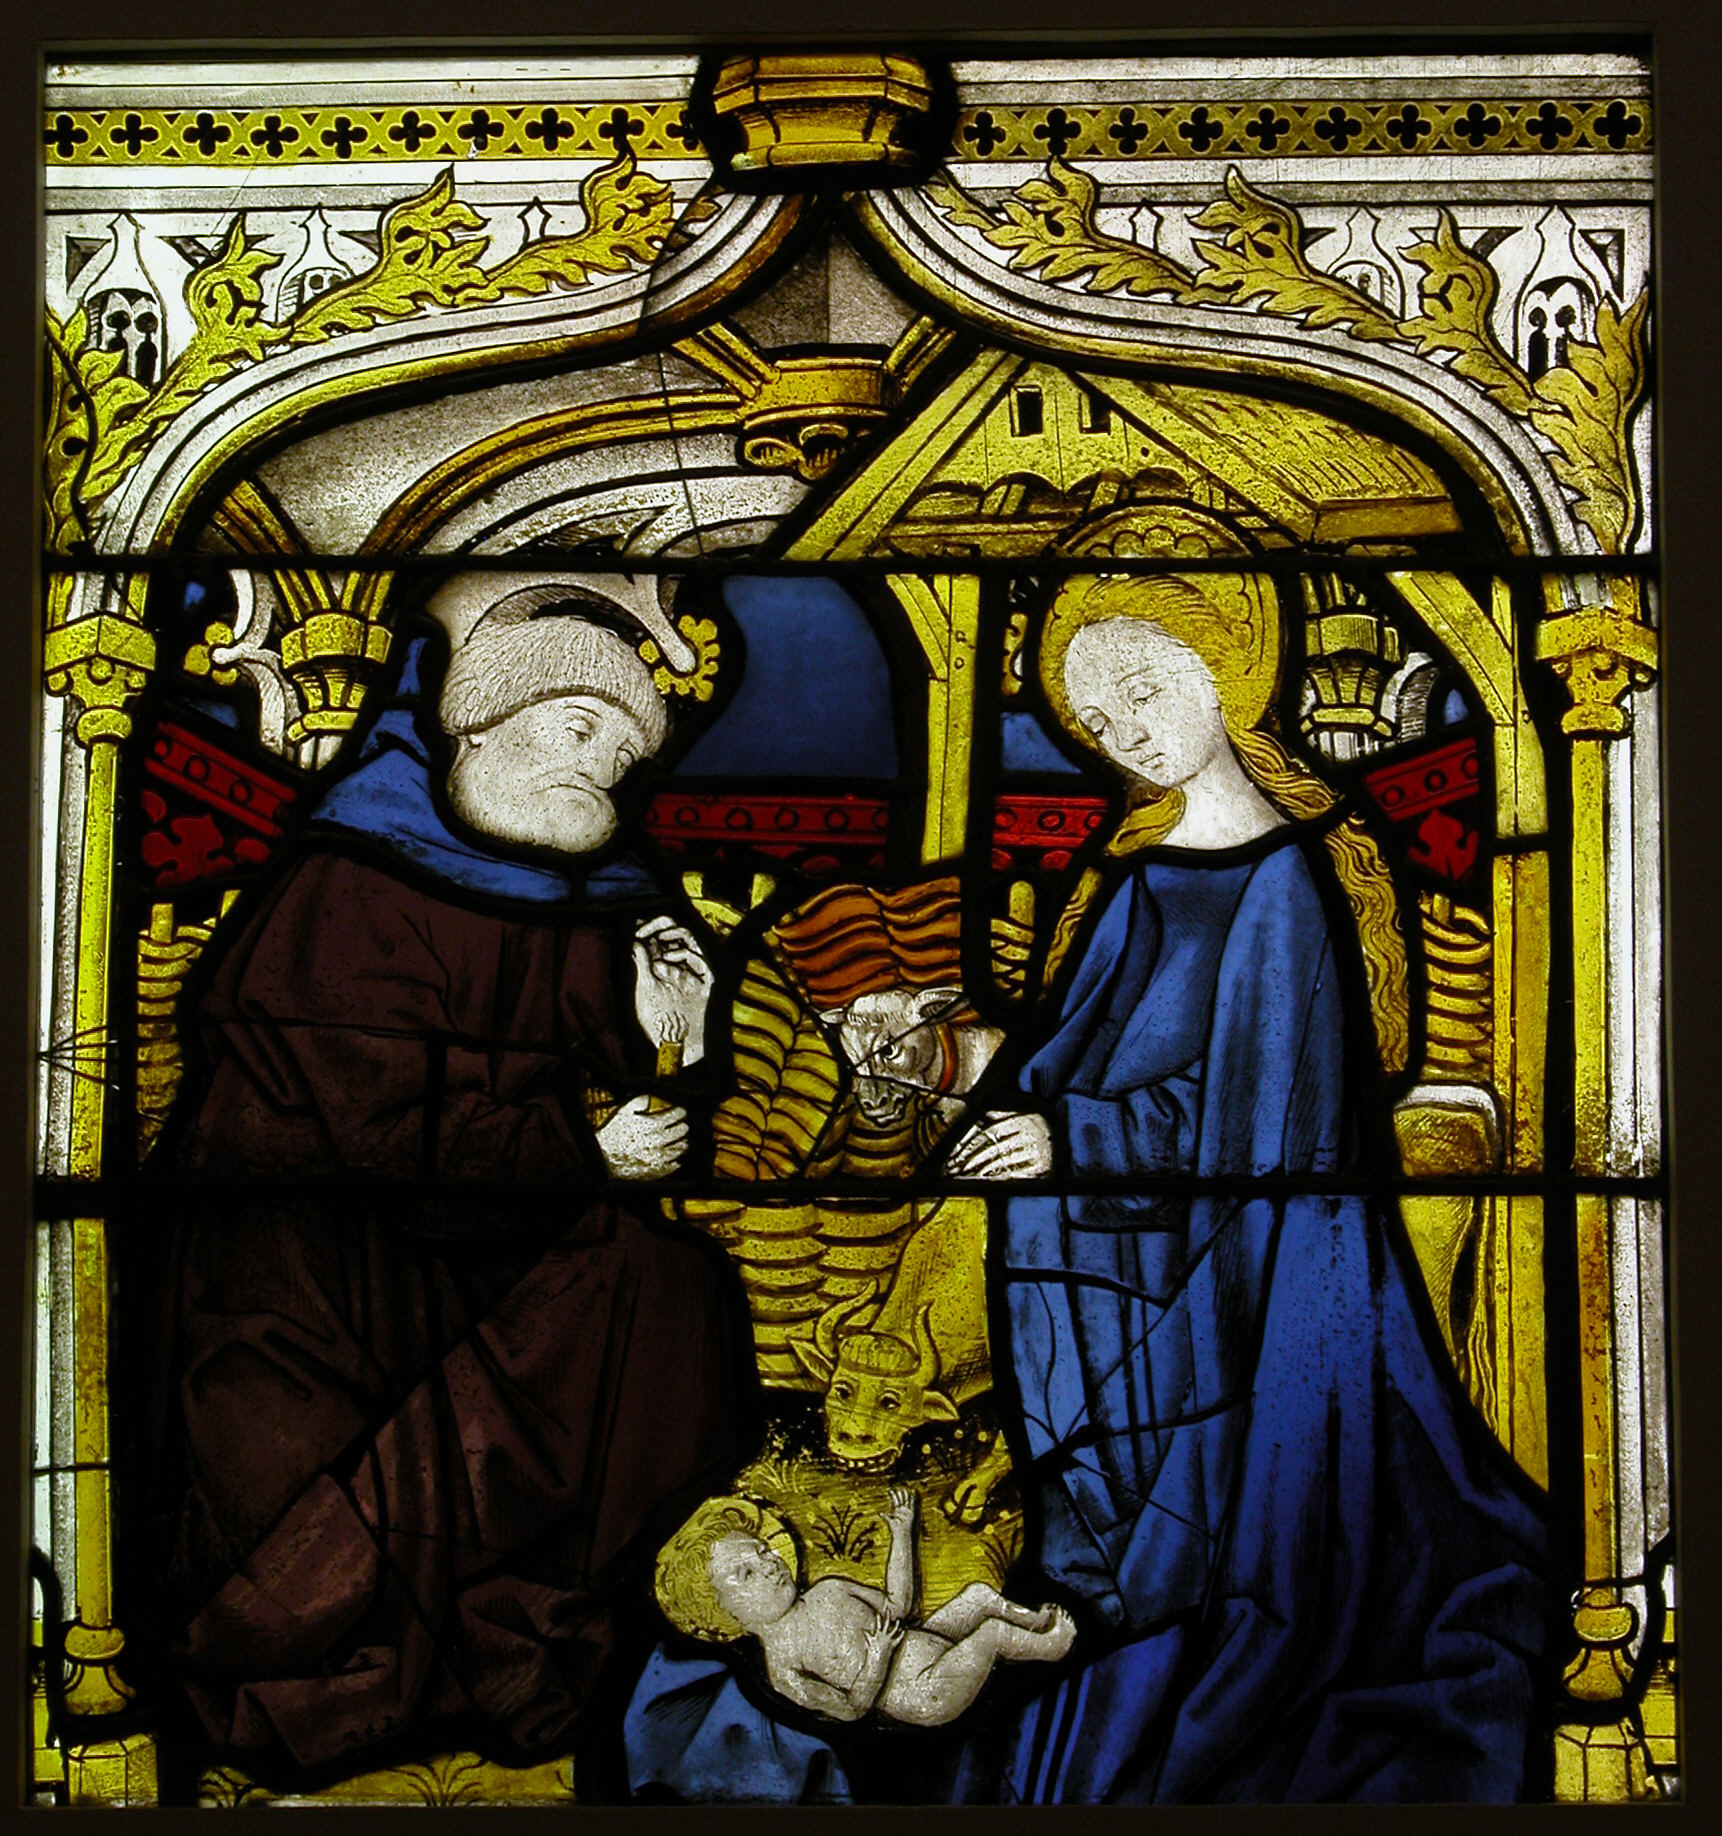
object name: panel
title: The Nativity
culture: french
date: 1440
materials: glass, metal, paint, pigment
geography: france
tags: animals,christ,virgin mary,saints